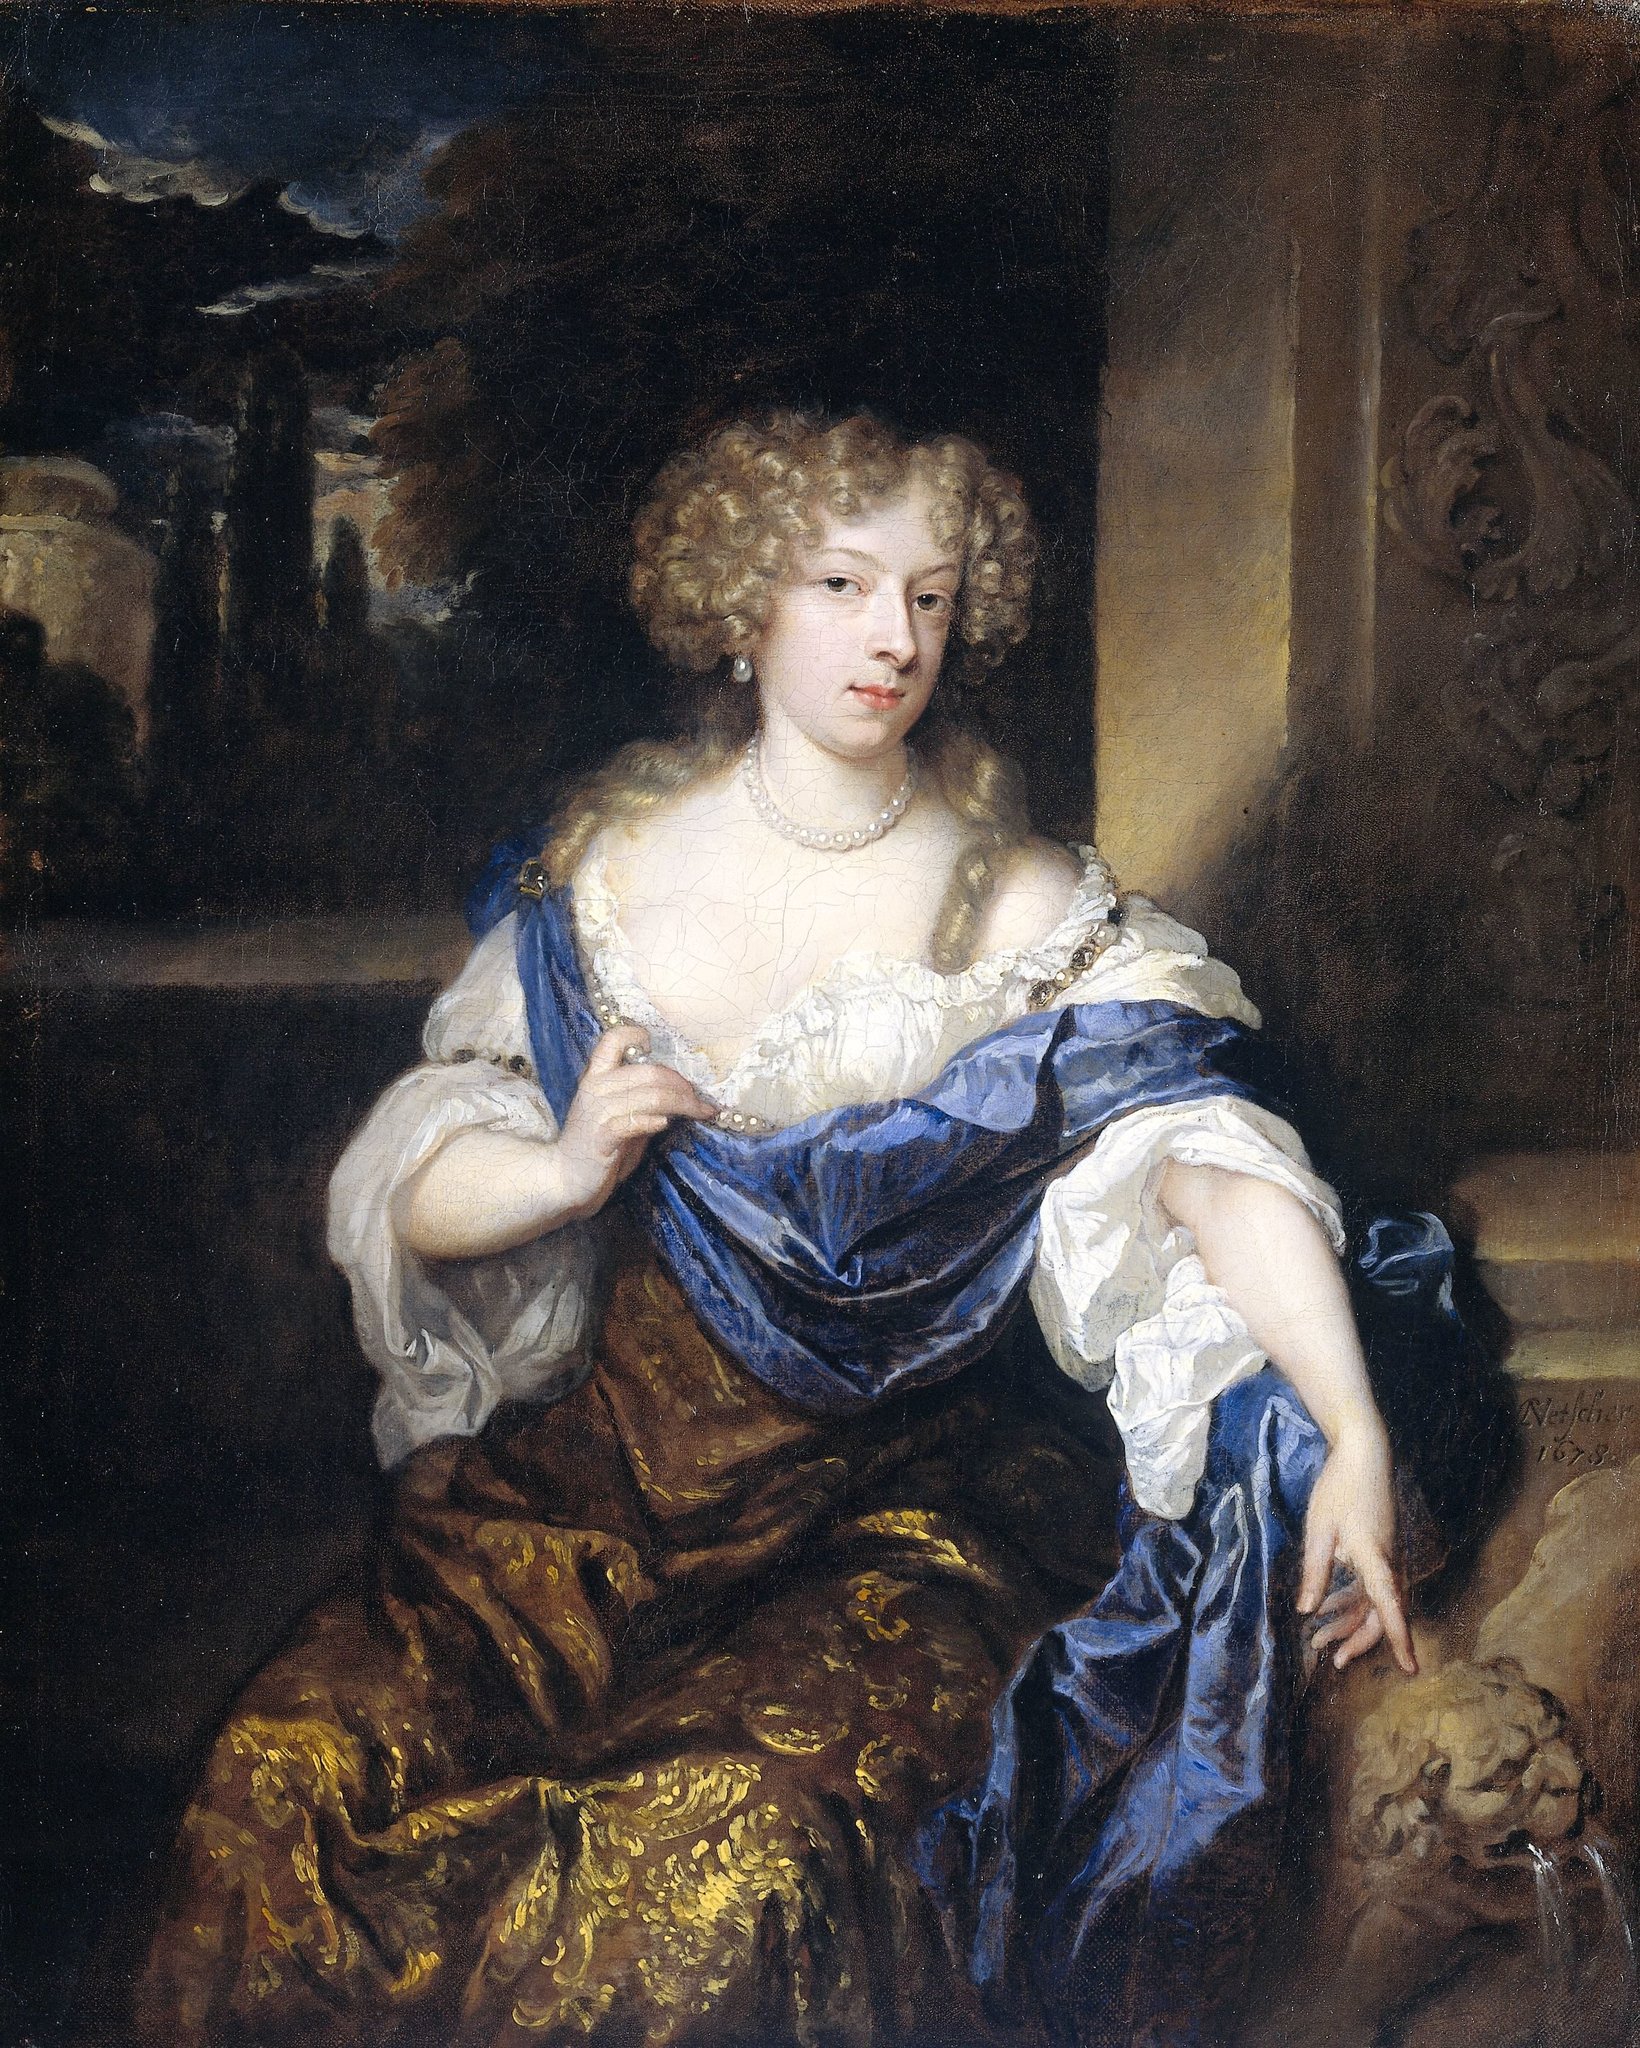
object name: painting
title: Portrait of Helena Ctaharina de Witte 91661-95), wife of Iman mogge, lord of Haamstede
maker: caspar netscher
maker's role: draughtsman, painter, print maker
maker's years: 1639-1684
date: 1678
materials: canvas, oil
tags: historical persons - bb - woman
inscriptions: signature and date: ‘CNetscher 1678’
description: Portret van Helena Catharina de Witte, de echtgenote van Iman Mogge, heer van Haamstede. Kniestuk, zittend, wijzend met de linkerhand naar een fontein in de vorm van een leeuw, de rechterhand op de parelsnoer om de hals. Op de achtergrond een landschap in maanlicht.